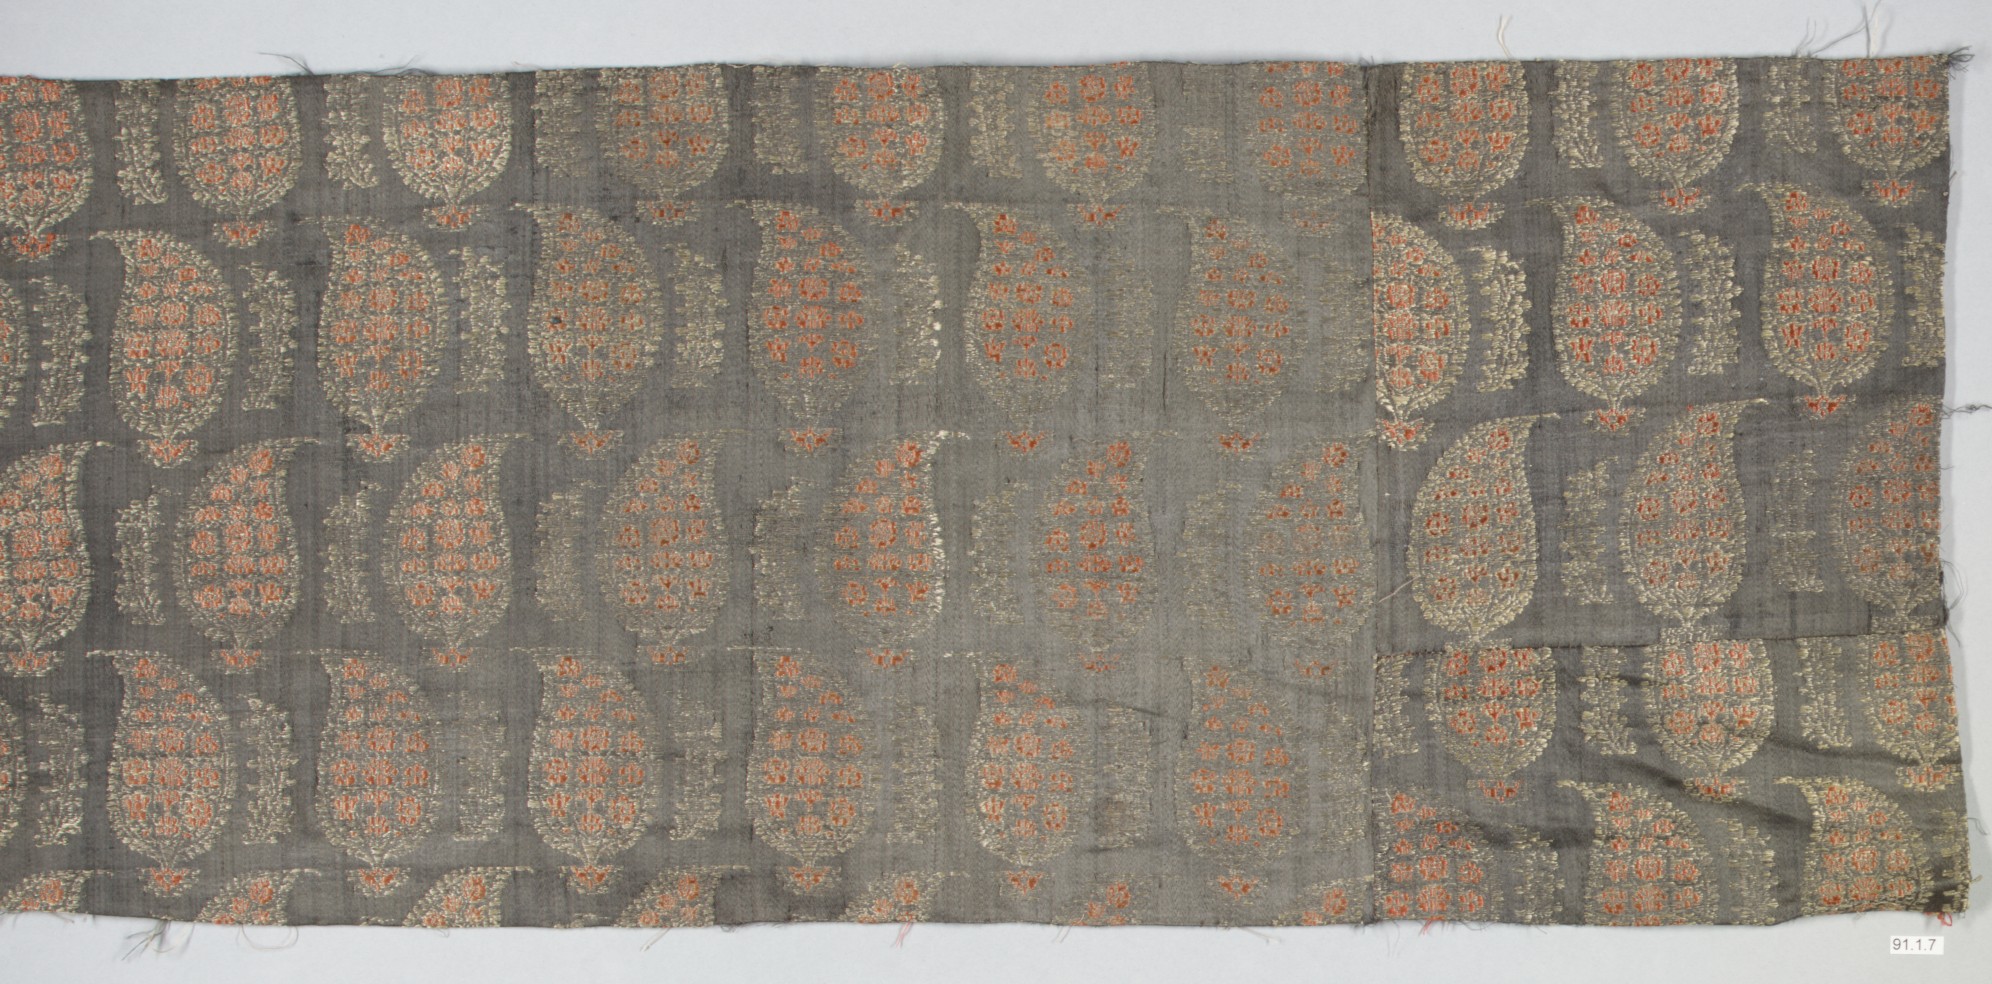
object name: textile fragment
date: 1701-1900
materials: silk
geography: india